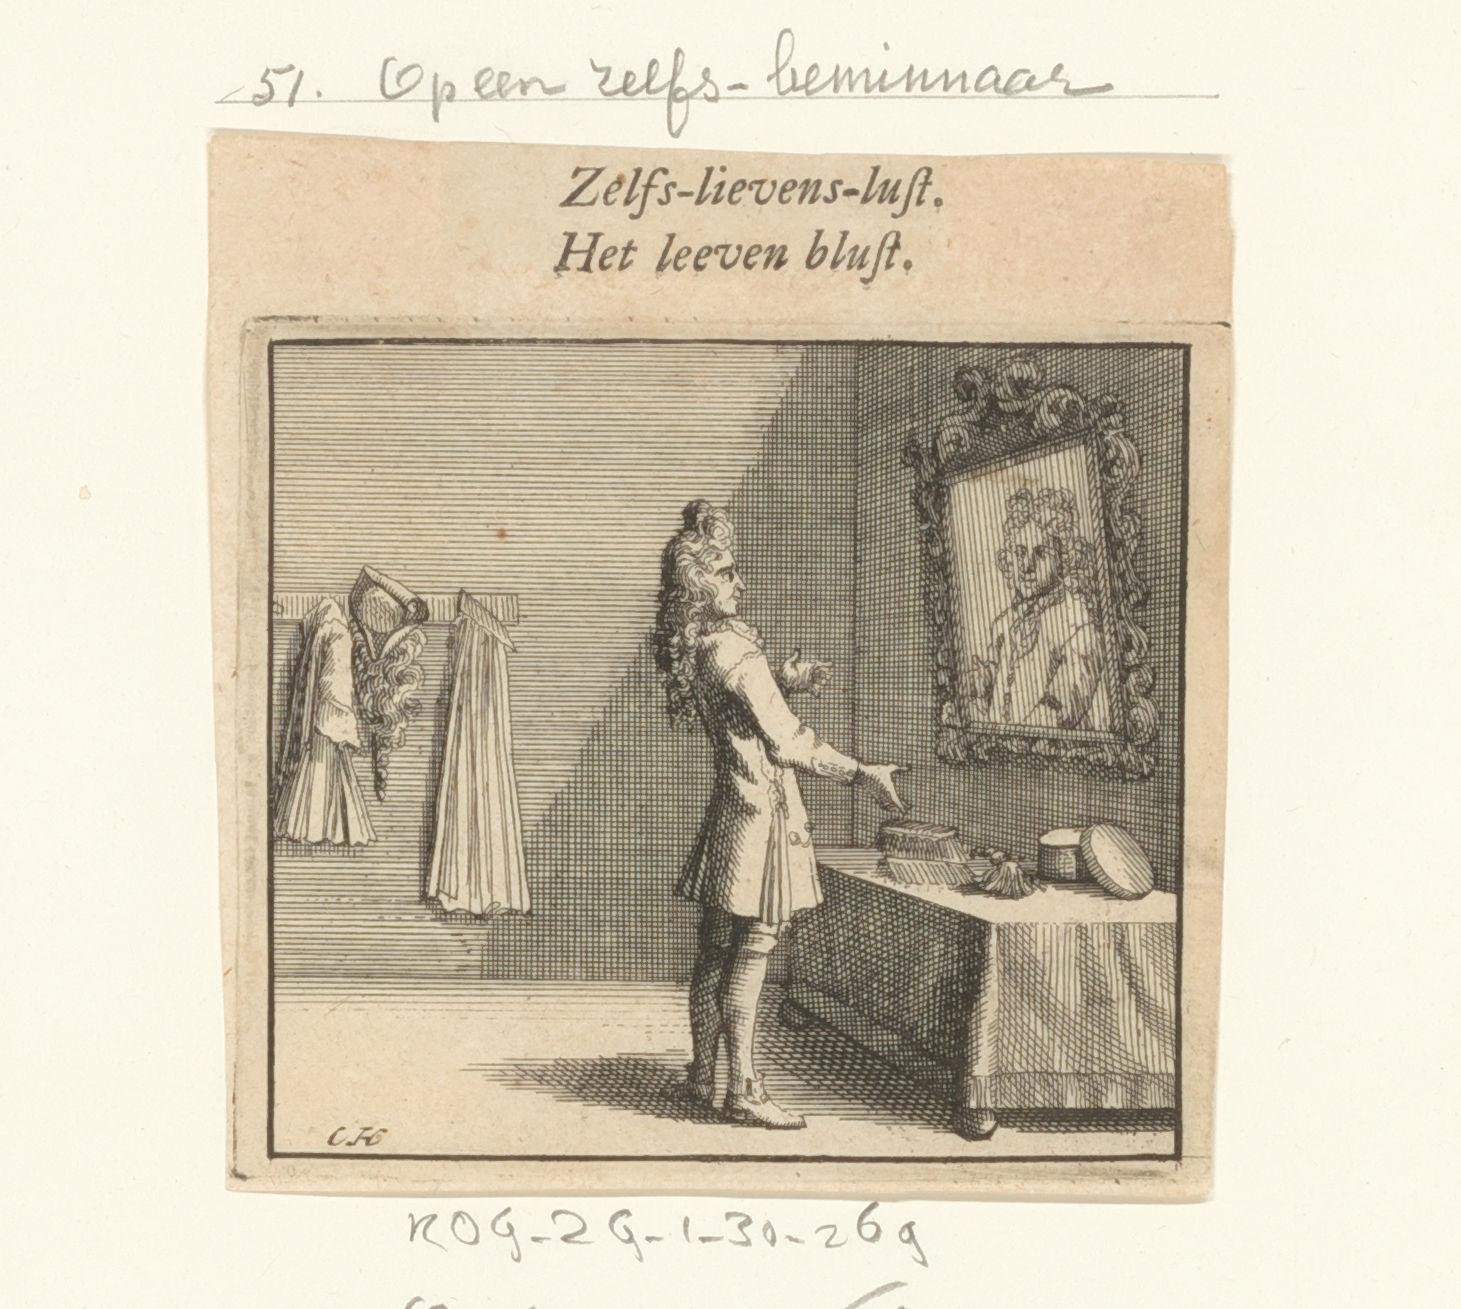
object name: print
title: Zelfs-lievens-lust, Het leeven bluft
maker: cornelis huyberts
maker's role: print maker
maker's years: 1669-1709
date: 1725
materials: paper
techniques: etching, letterpress printing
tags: mirror, looking in the mirror; contemplation of own beauty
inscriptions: stamp, collector's mark: Lugt 1641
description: Prent uit: Graauwhart, Hendrik. Voorbeeldelyke zeede-lessen, genoomen uyt den eersten toestand des werelds (...). Amsterdam: Johannes Ratelband, 1725. Prent ook gebruikt voor eerdere en (1709) latere uitgave (1756, 1761 en 1764).